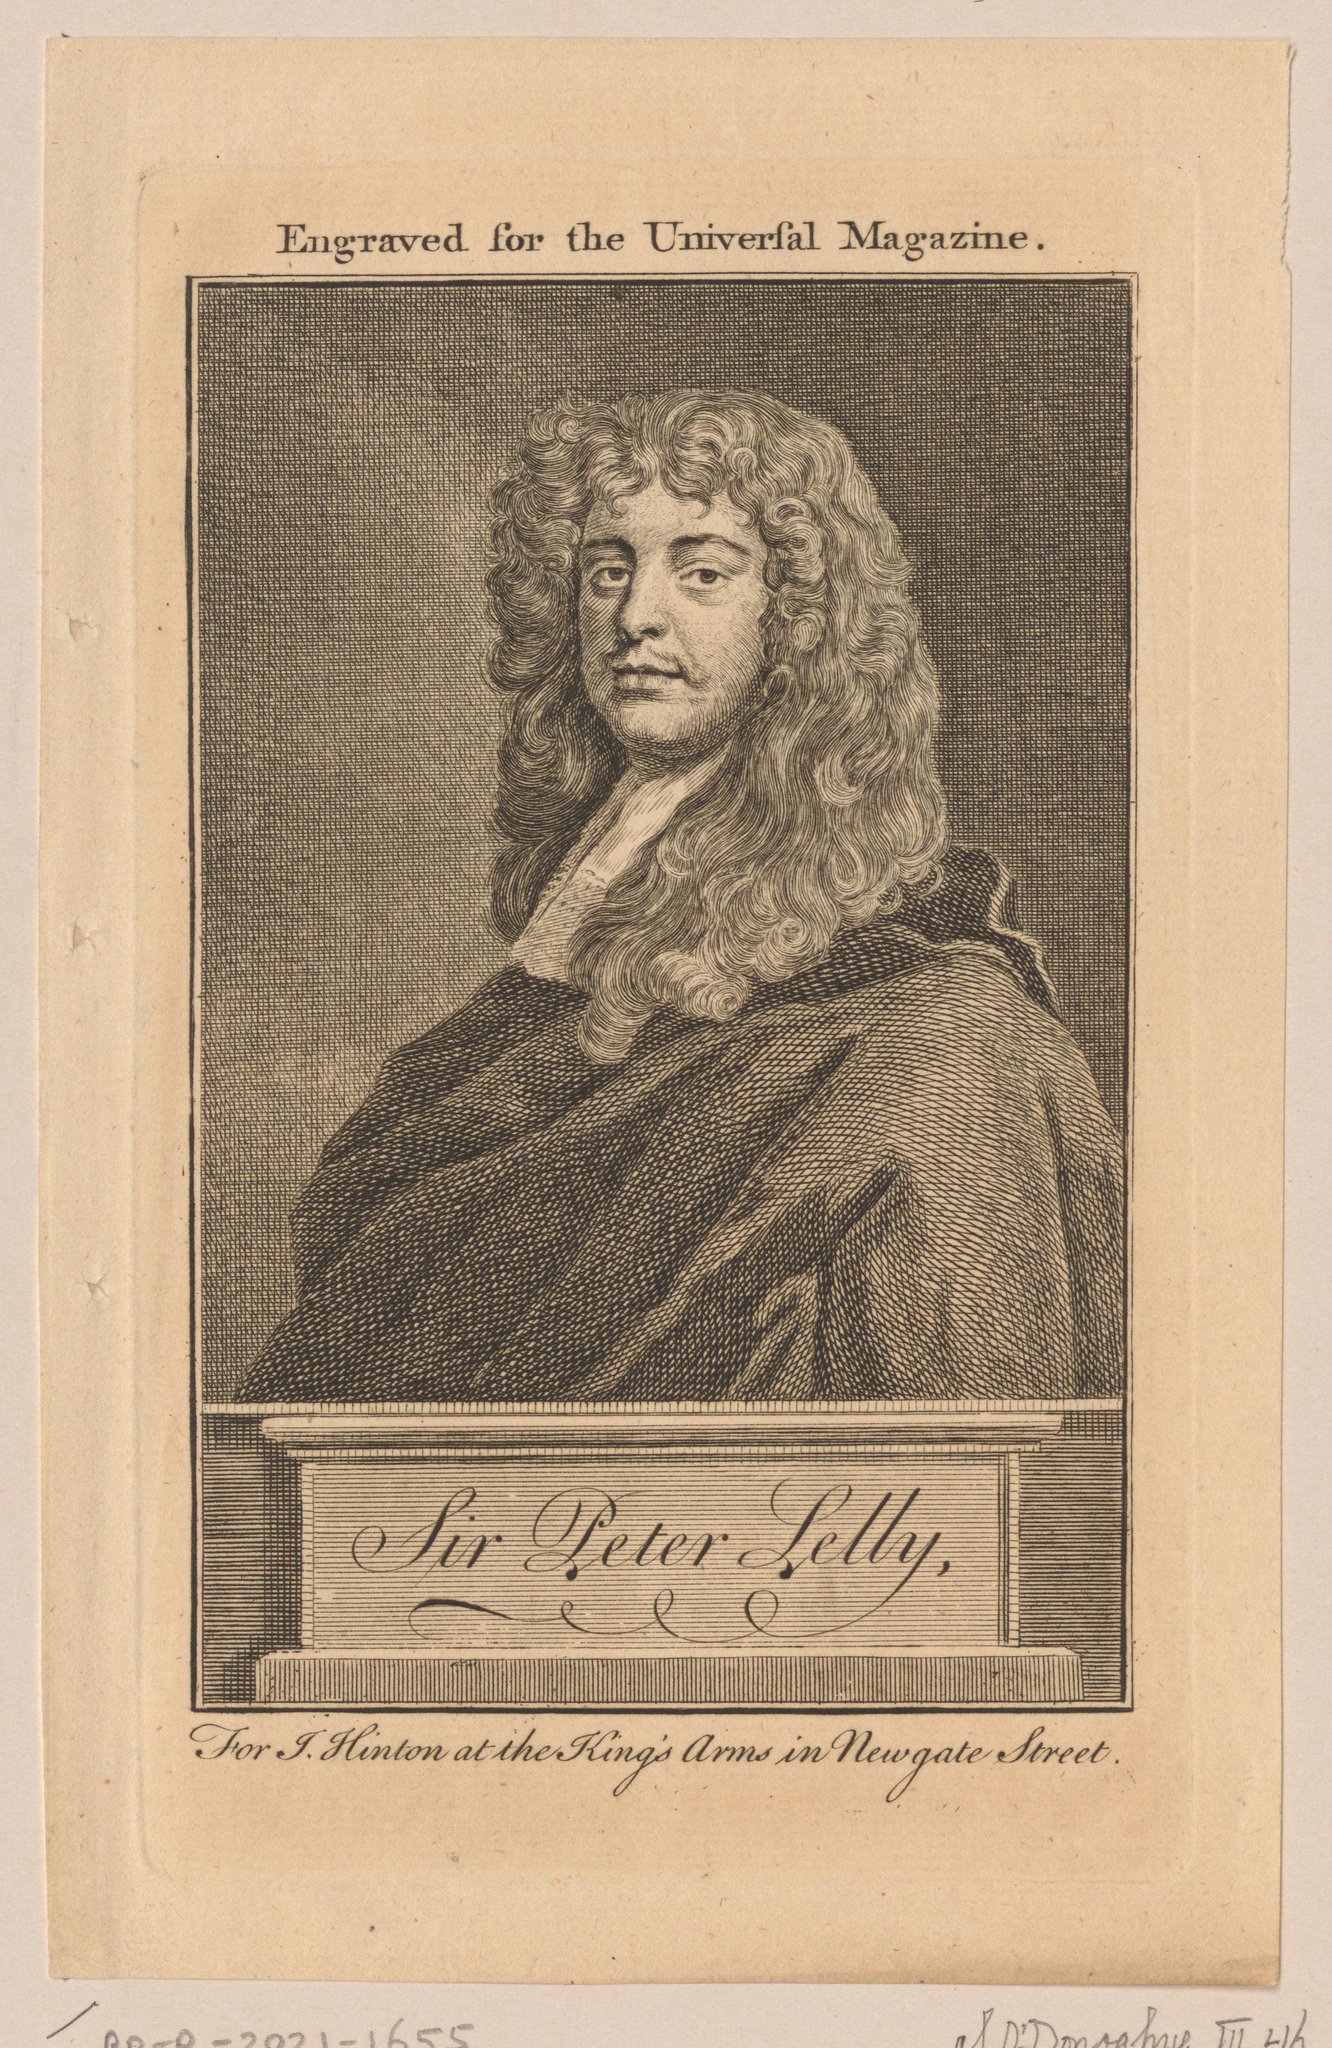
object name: print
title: Portret van Peter Lely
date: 1747-1781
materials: paper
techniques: engraving, etching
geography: england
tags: london, painter, peter lely (sir), historical persons, portrait, self-portrait of painter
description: Prent komt uit een editie van The Universal Magazine.